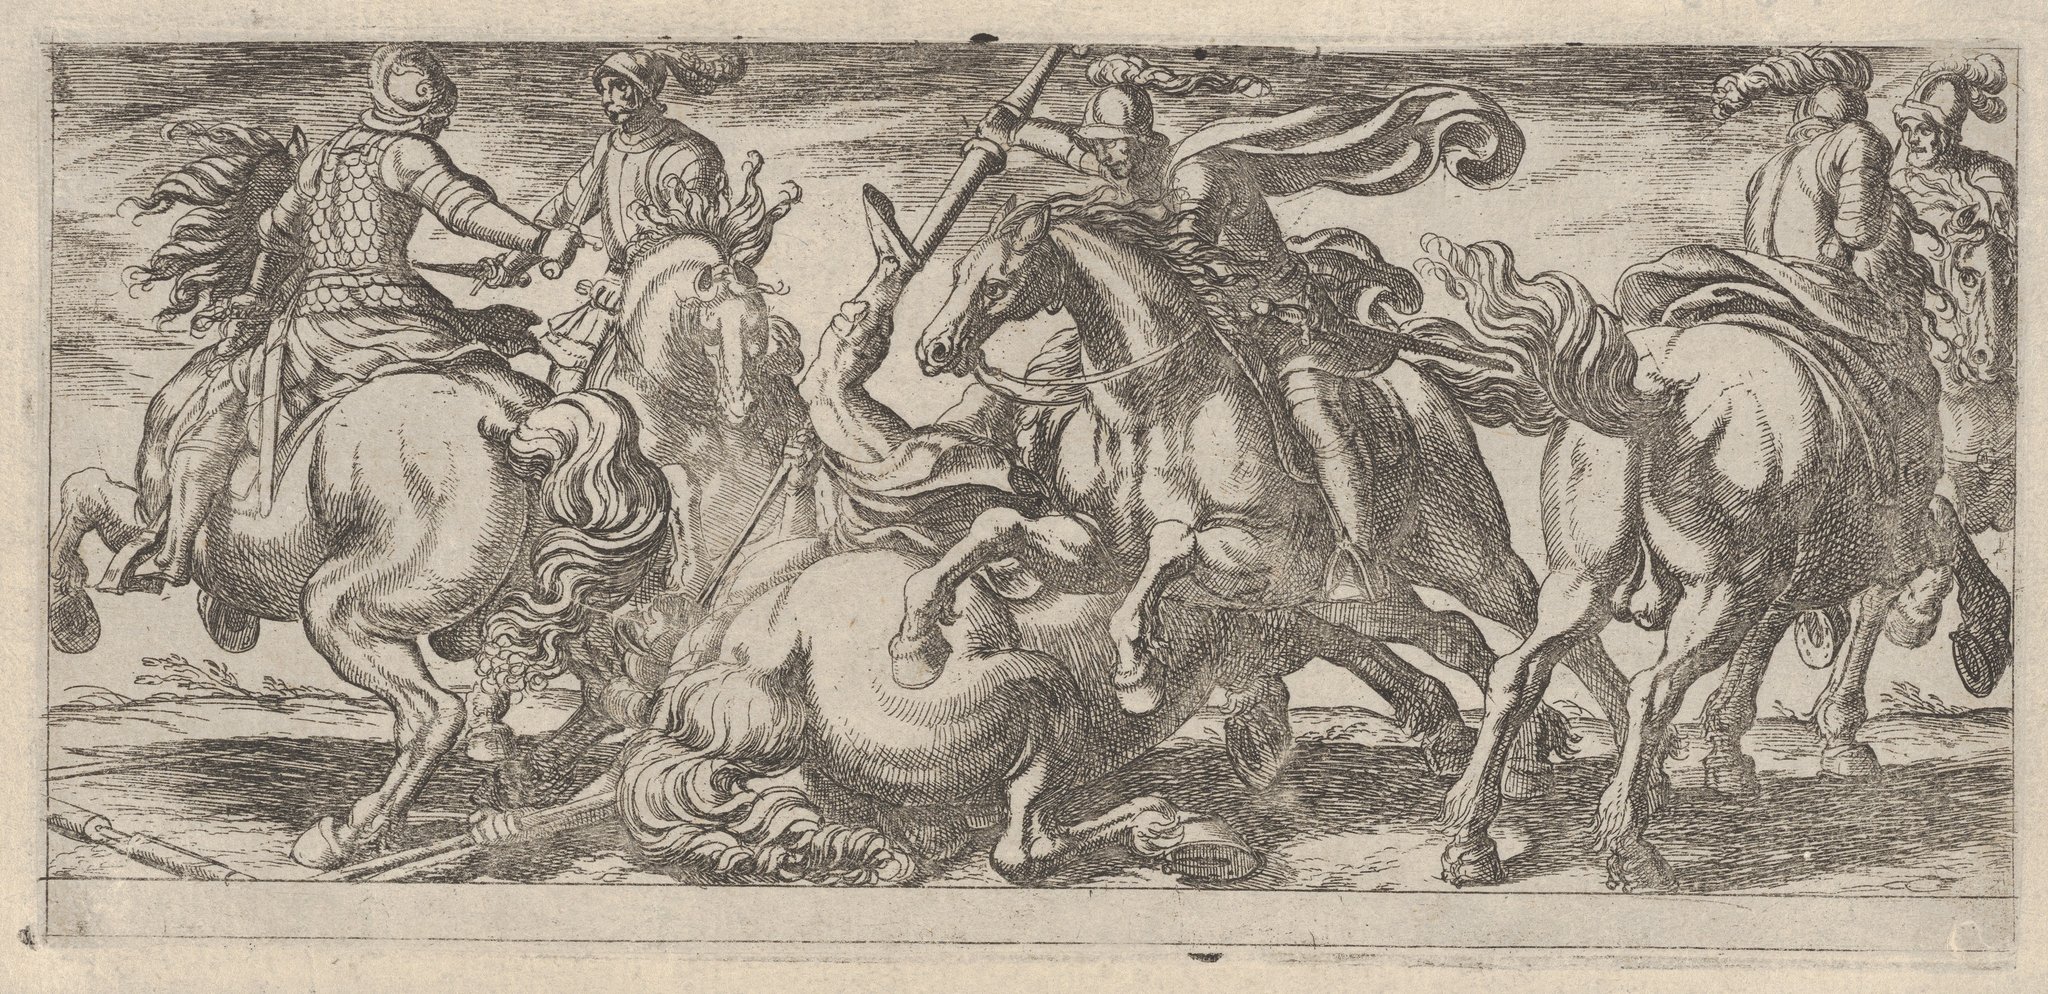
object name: print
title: Six Cavalrymen in Combat, from "Battle Scenes I"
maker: antonio tempesta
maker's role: artist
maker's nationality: italian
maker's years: 1555-1630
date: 1590-1630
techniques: etching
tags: battles,weapons,men,horses